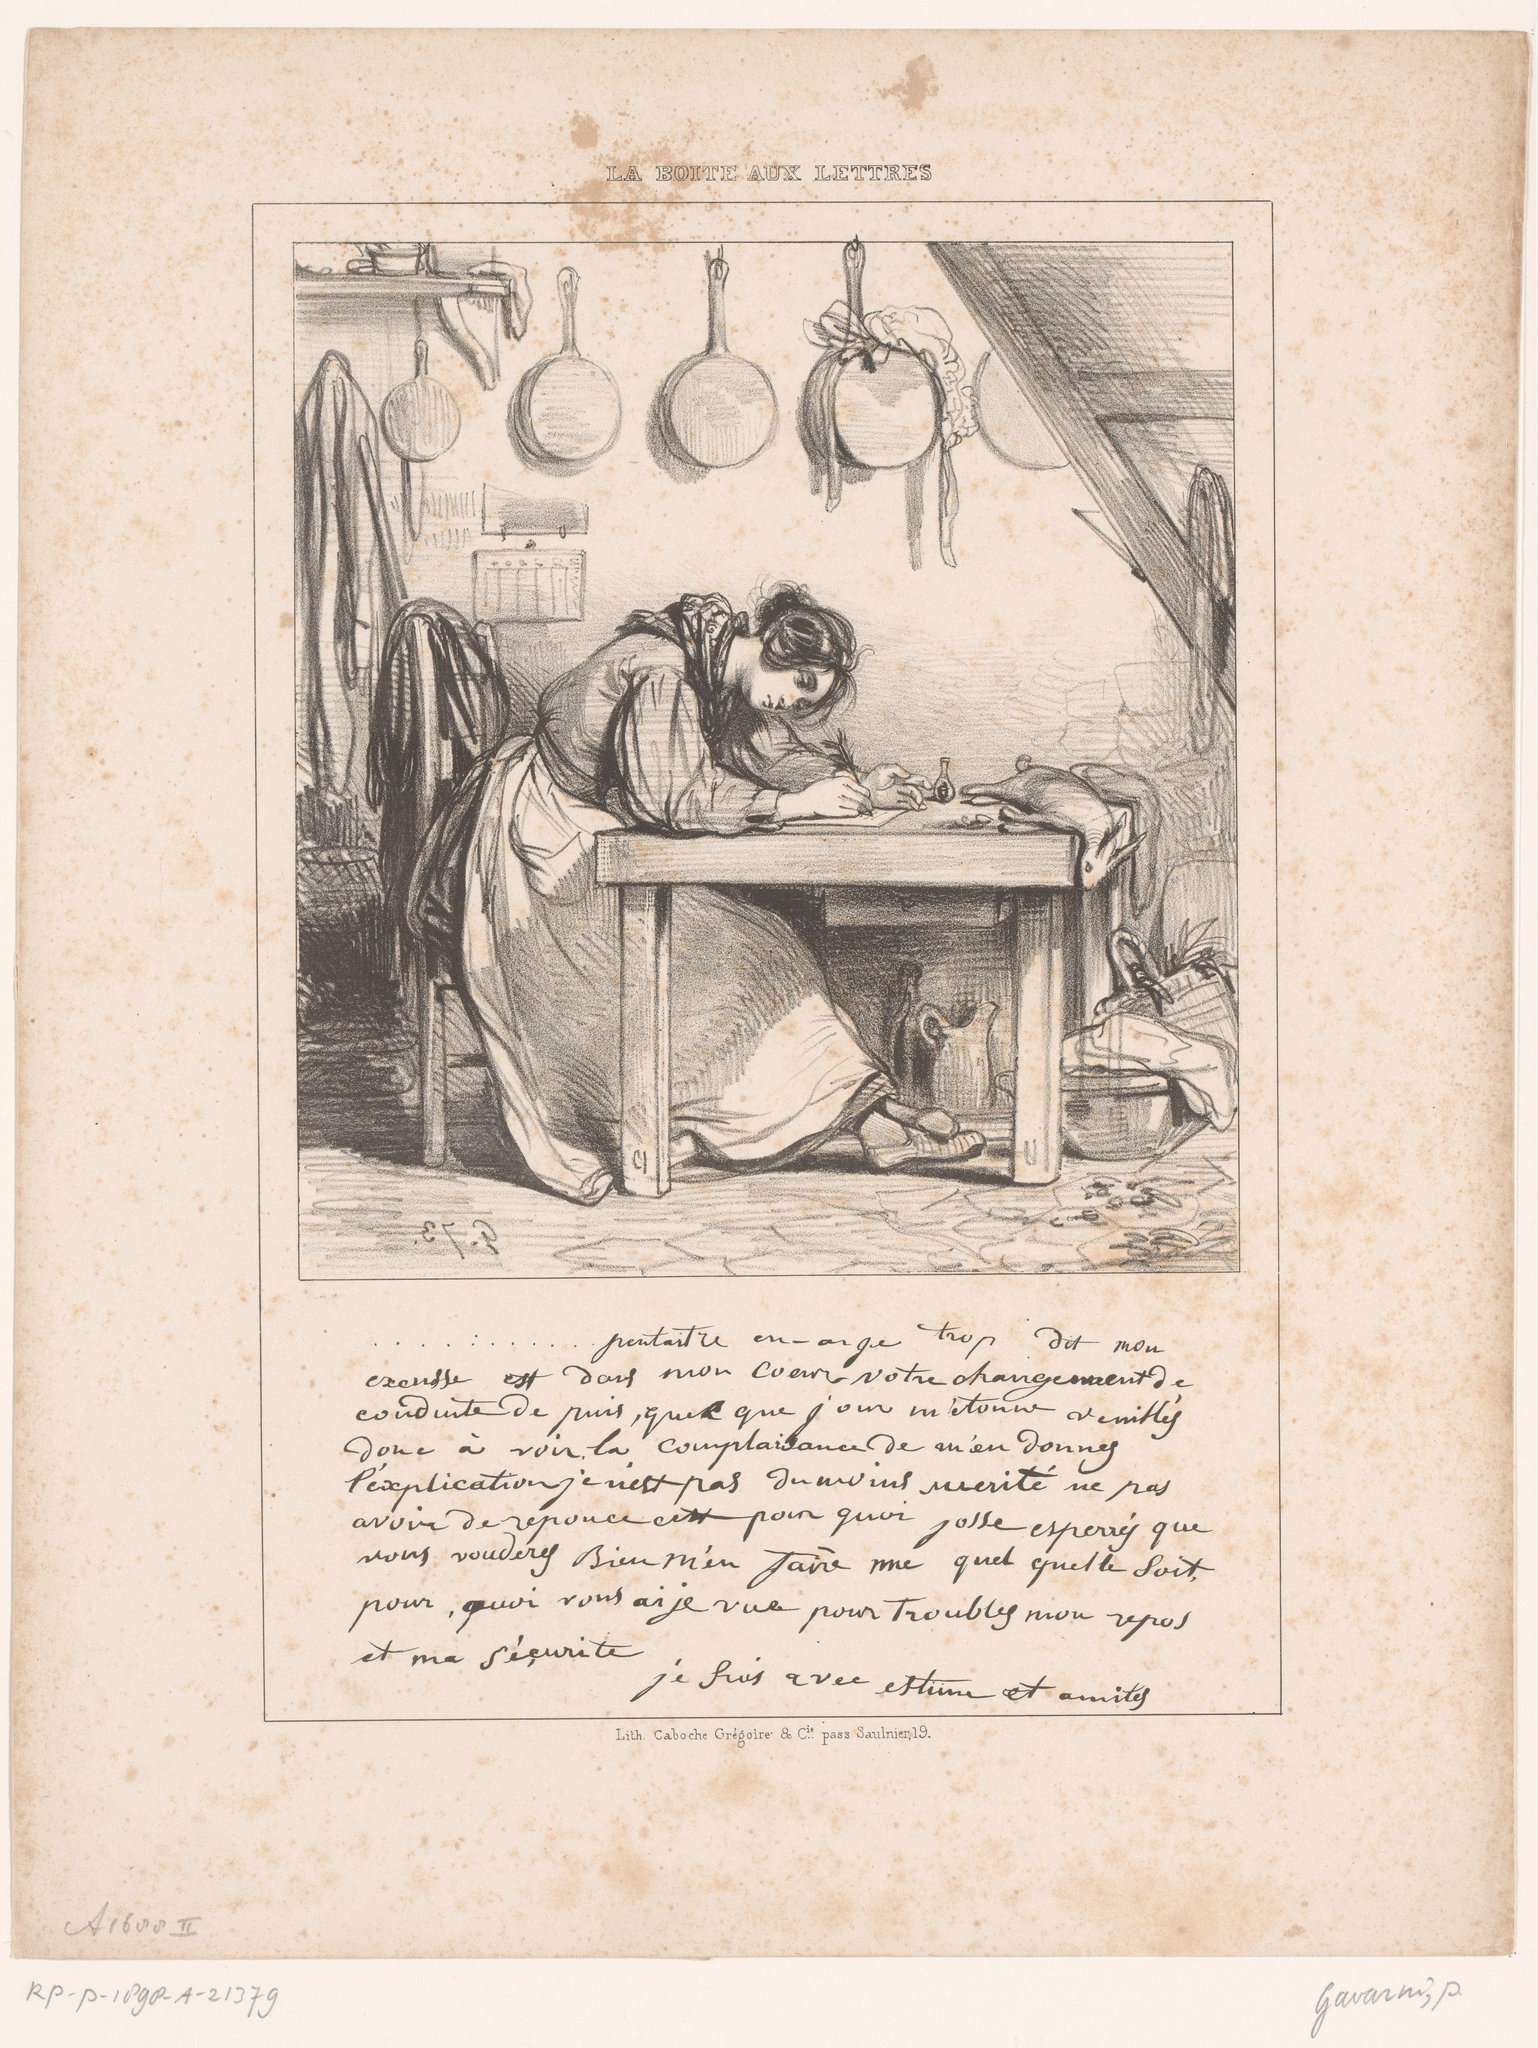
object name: cartoon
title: La boîte aux lettres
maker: paul gavarni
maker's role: draughtsman, print maker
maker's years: 1804-1866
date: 1837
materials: paper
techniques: lithograph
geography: paris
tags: handwriting, writing as activity, kitchen, sitting figure - aa - female human figure, letter, envelope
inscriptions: collector's mark: Lugt 964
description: Prent gebruikt voor: Le Charivari, 26 augustus 1837.